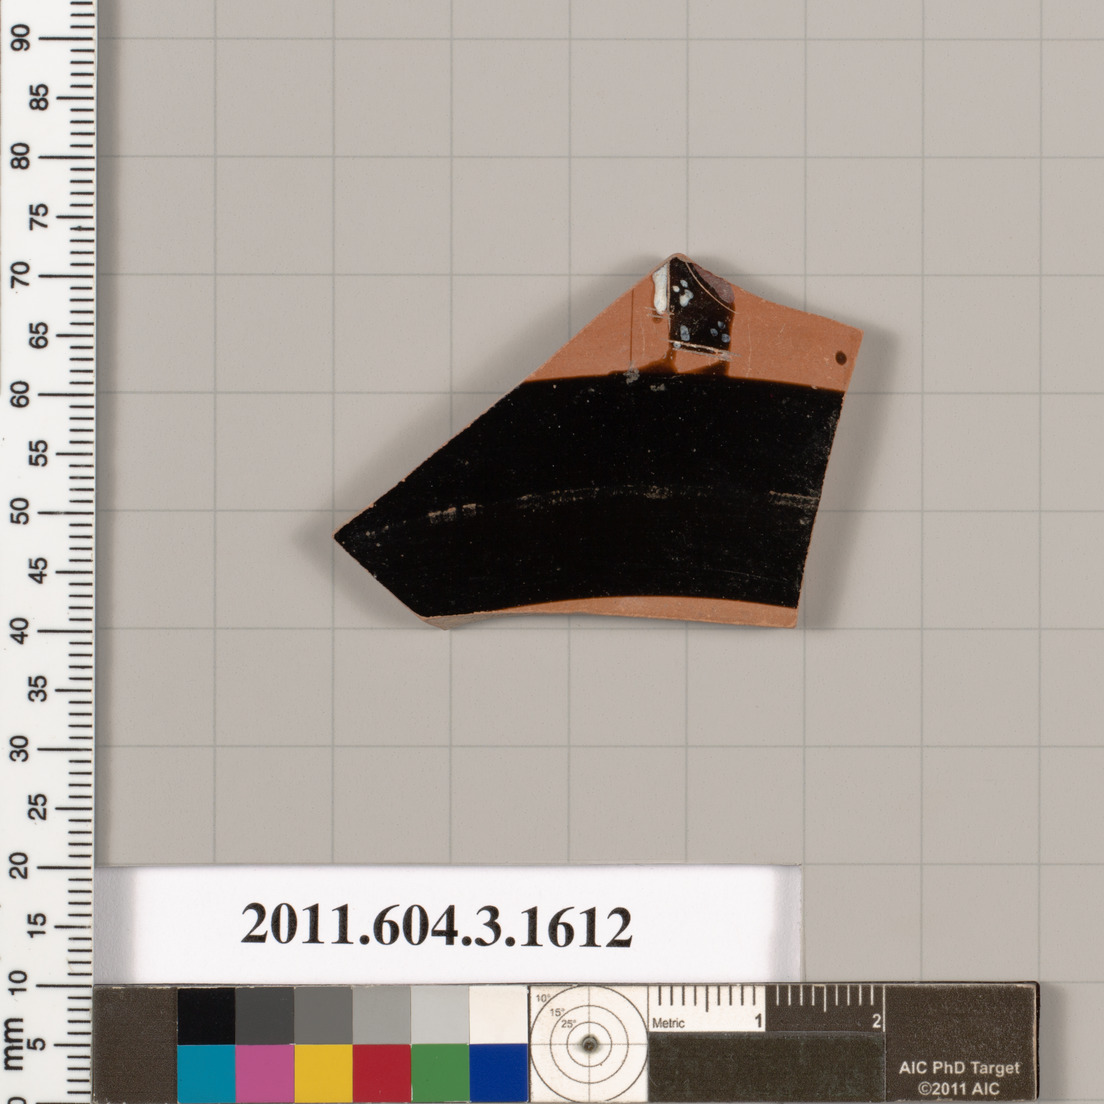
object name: kylix fragment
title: Terracotta fragment of a kylix: Band cup (drinking cup)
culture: greek, attic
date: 550-526 BCE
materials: terracotta